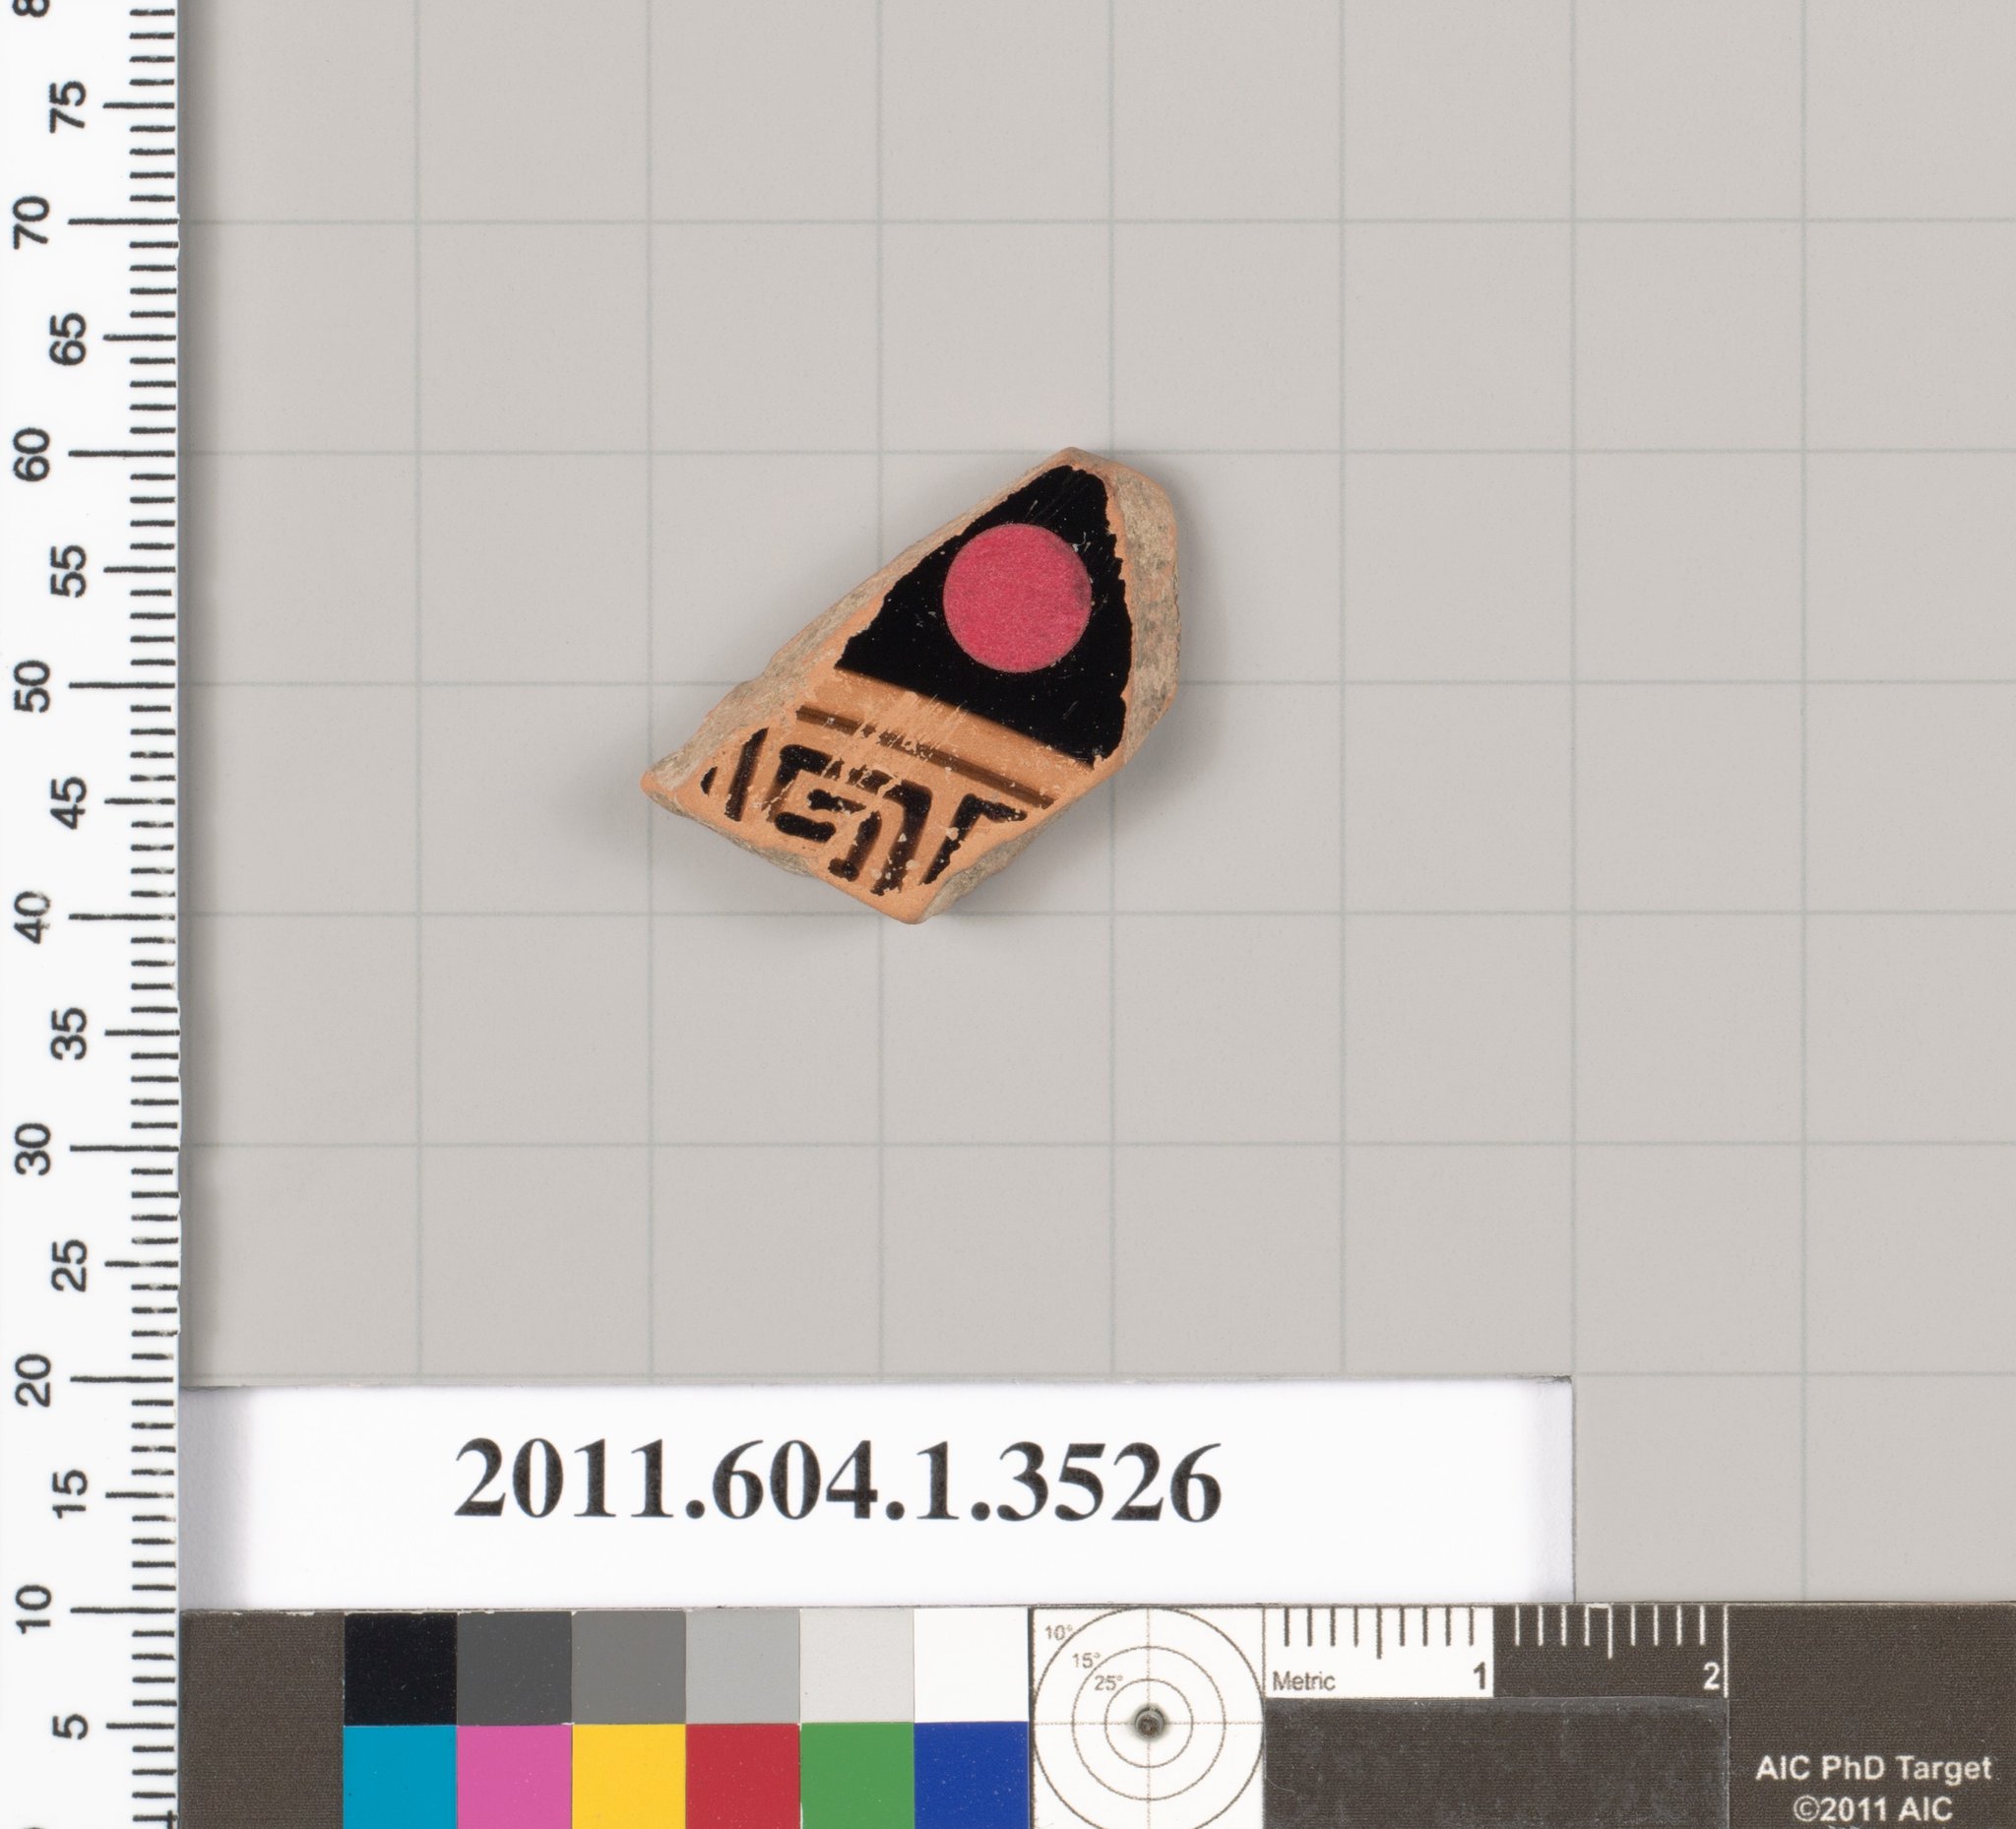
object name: kylix fragment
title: Terracotta fragment of a kylix (drinking cup)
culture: greek, attic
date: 490-470 BCE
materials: terracotta